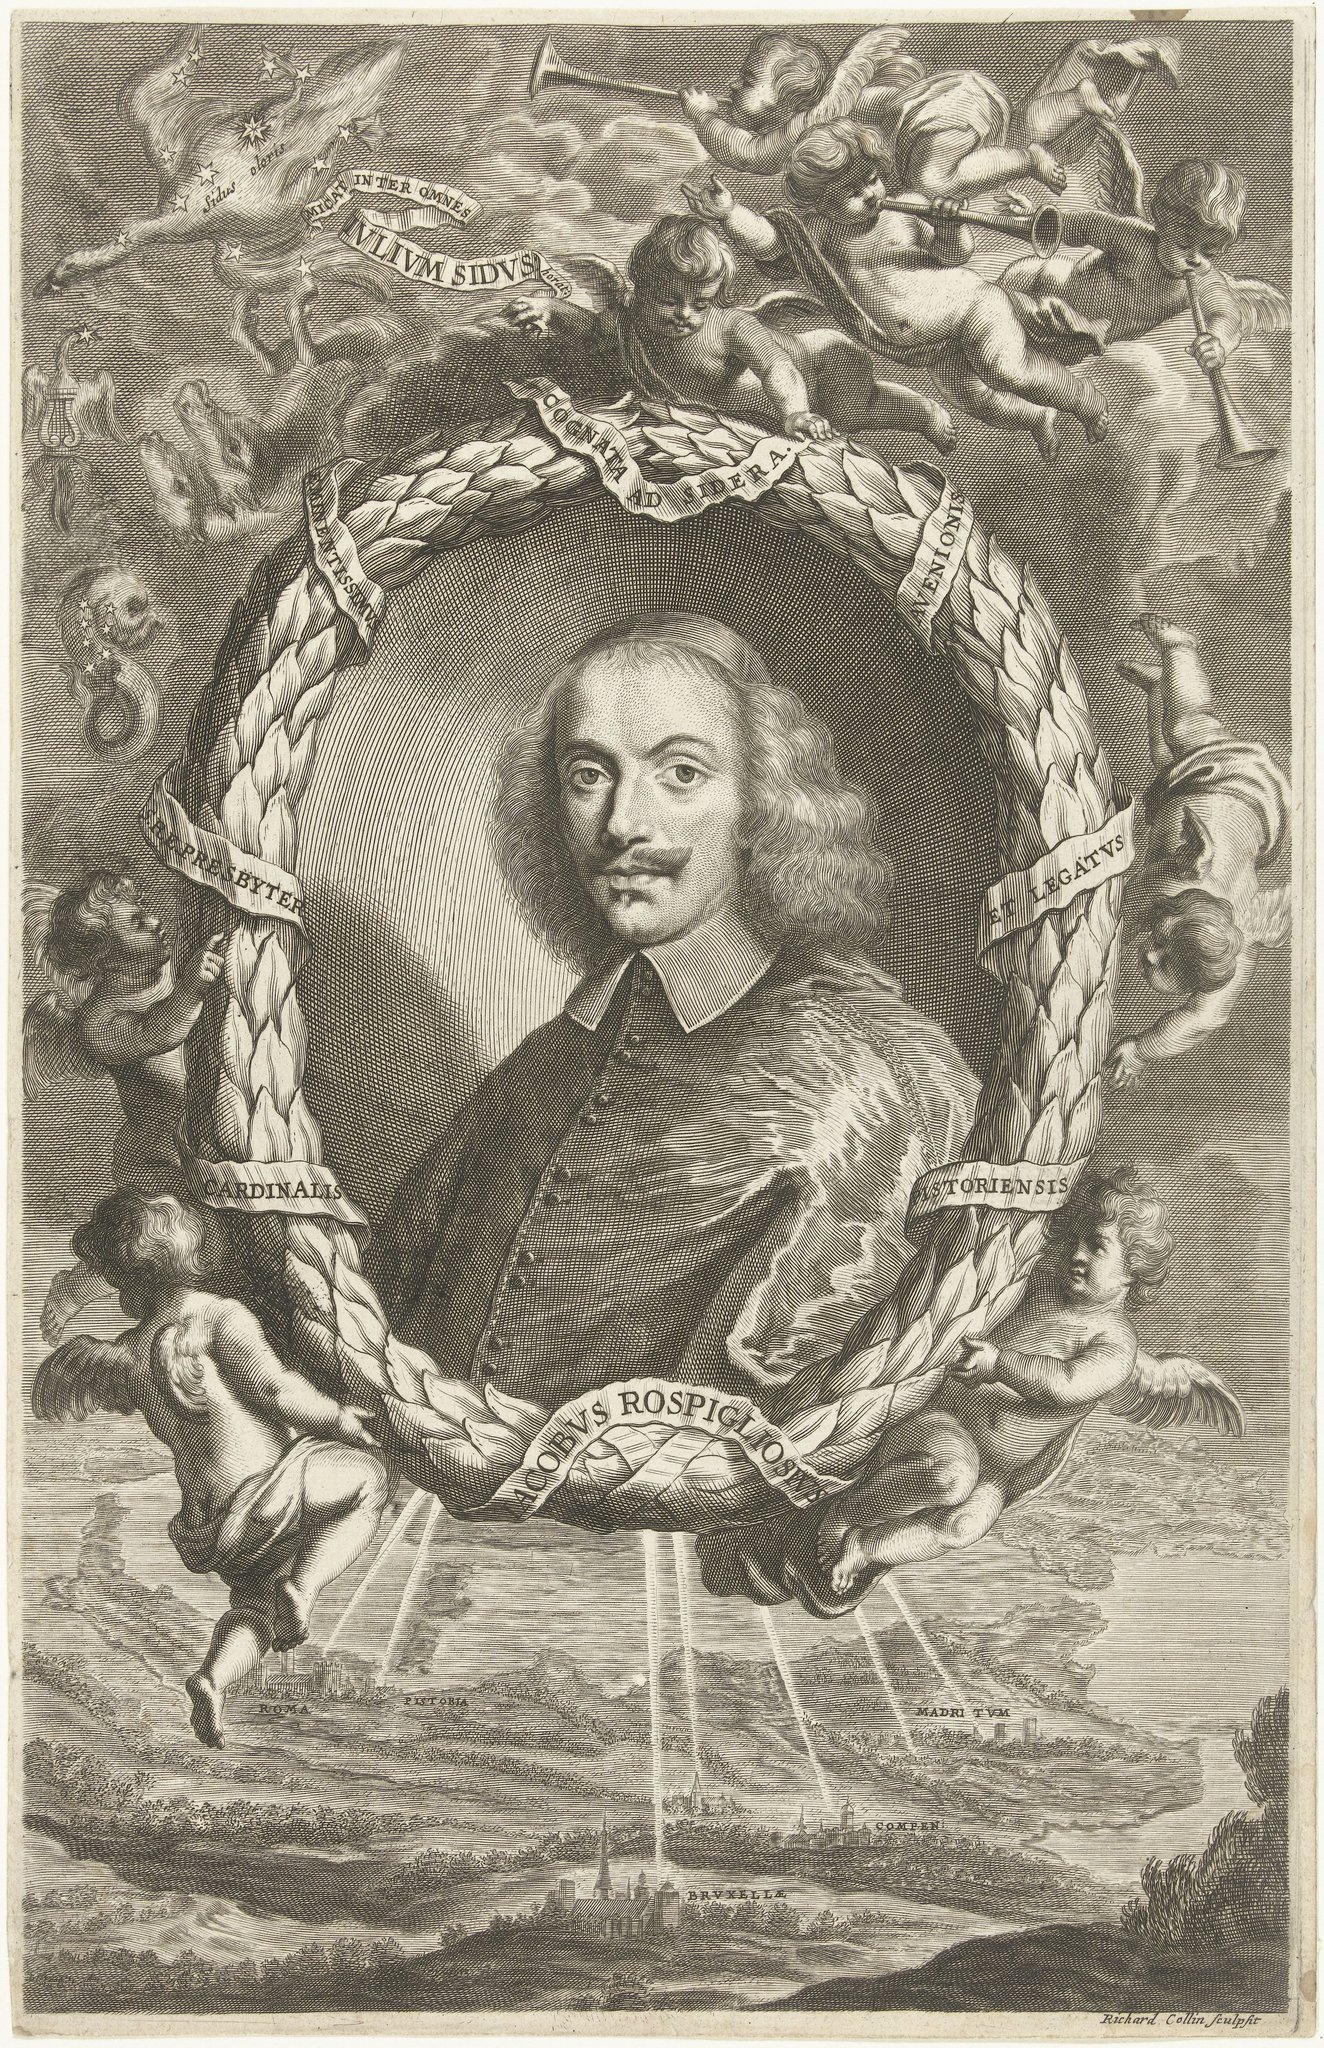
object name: print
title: Portret van kardinaal Giacomo Rospigliosi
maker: richard collin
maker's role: print maker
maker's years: 1627-1697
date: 1668-1697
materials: paper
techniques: engraving, etching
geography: antwerp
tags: giacomo rospigliosi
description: Borstbeeld van de kardinaal in een ovale omlijsting gedragen door engelen. Op de achtergrond een kaart met de steden die een belangrijke rol speelden in Rospigliosi's leven.